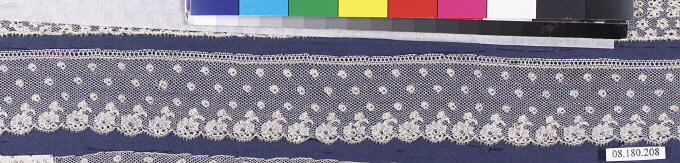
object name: fragment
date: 1801-1900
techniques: lace